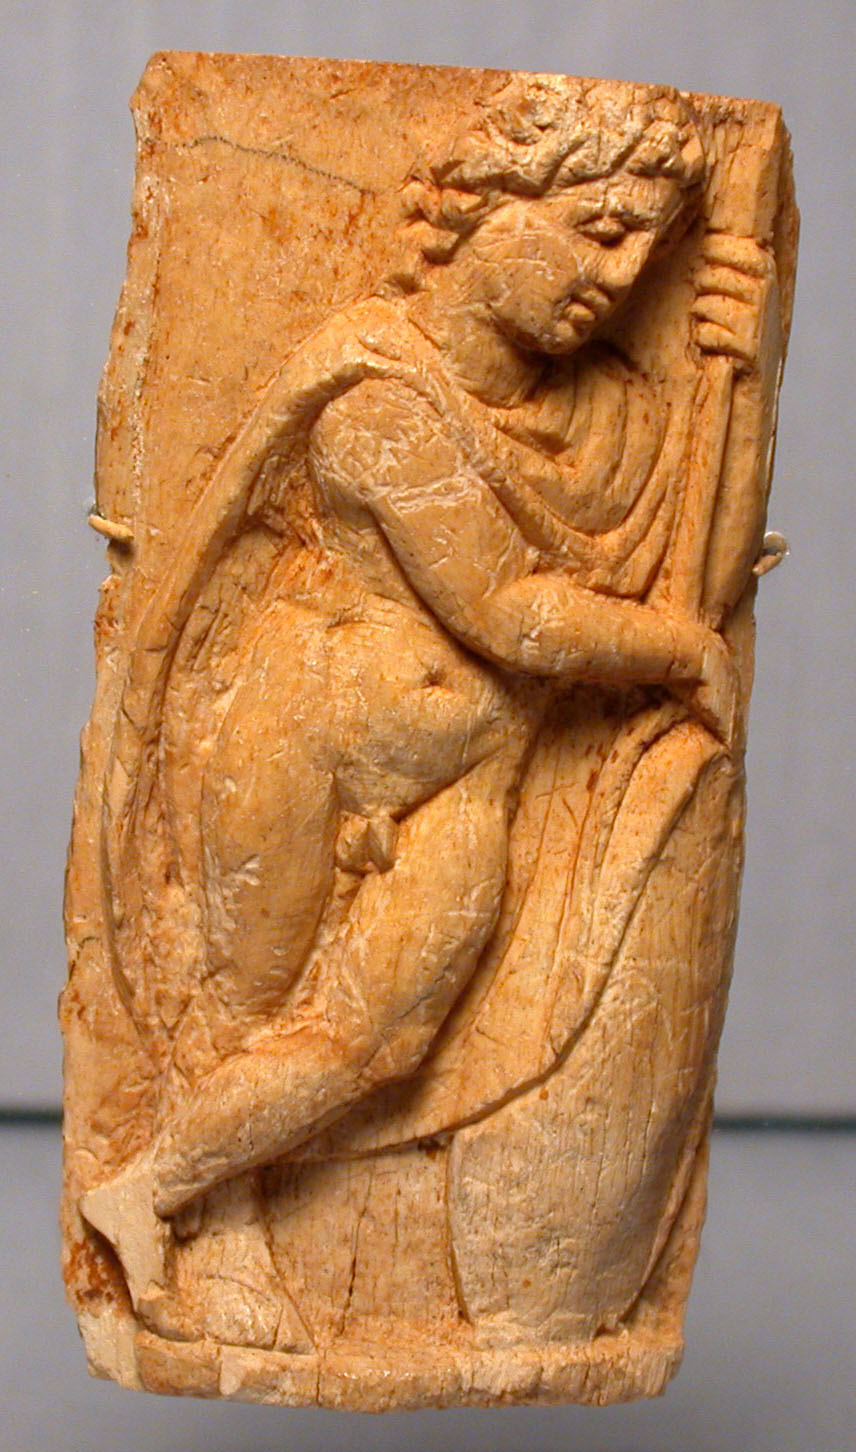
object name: plaque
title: Panel with Warrior Resting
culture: byzantine or roman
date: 301-600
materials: bone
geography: egypt